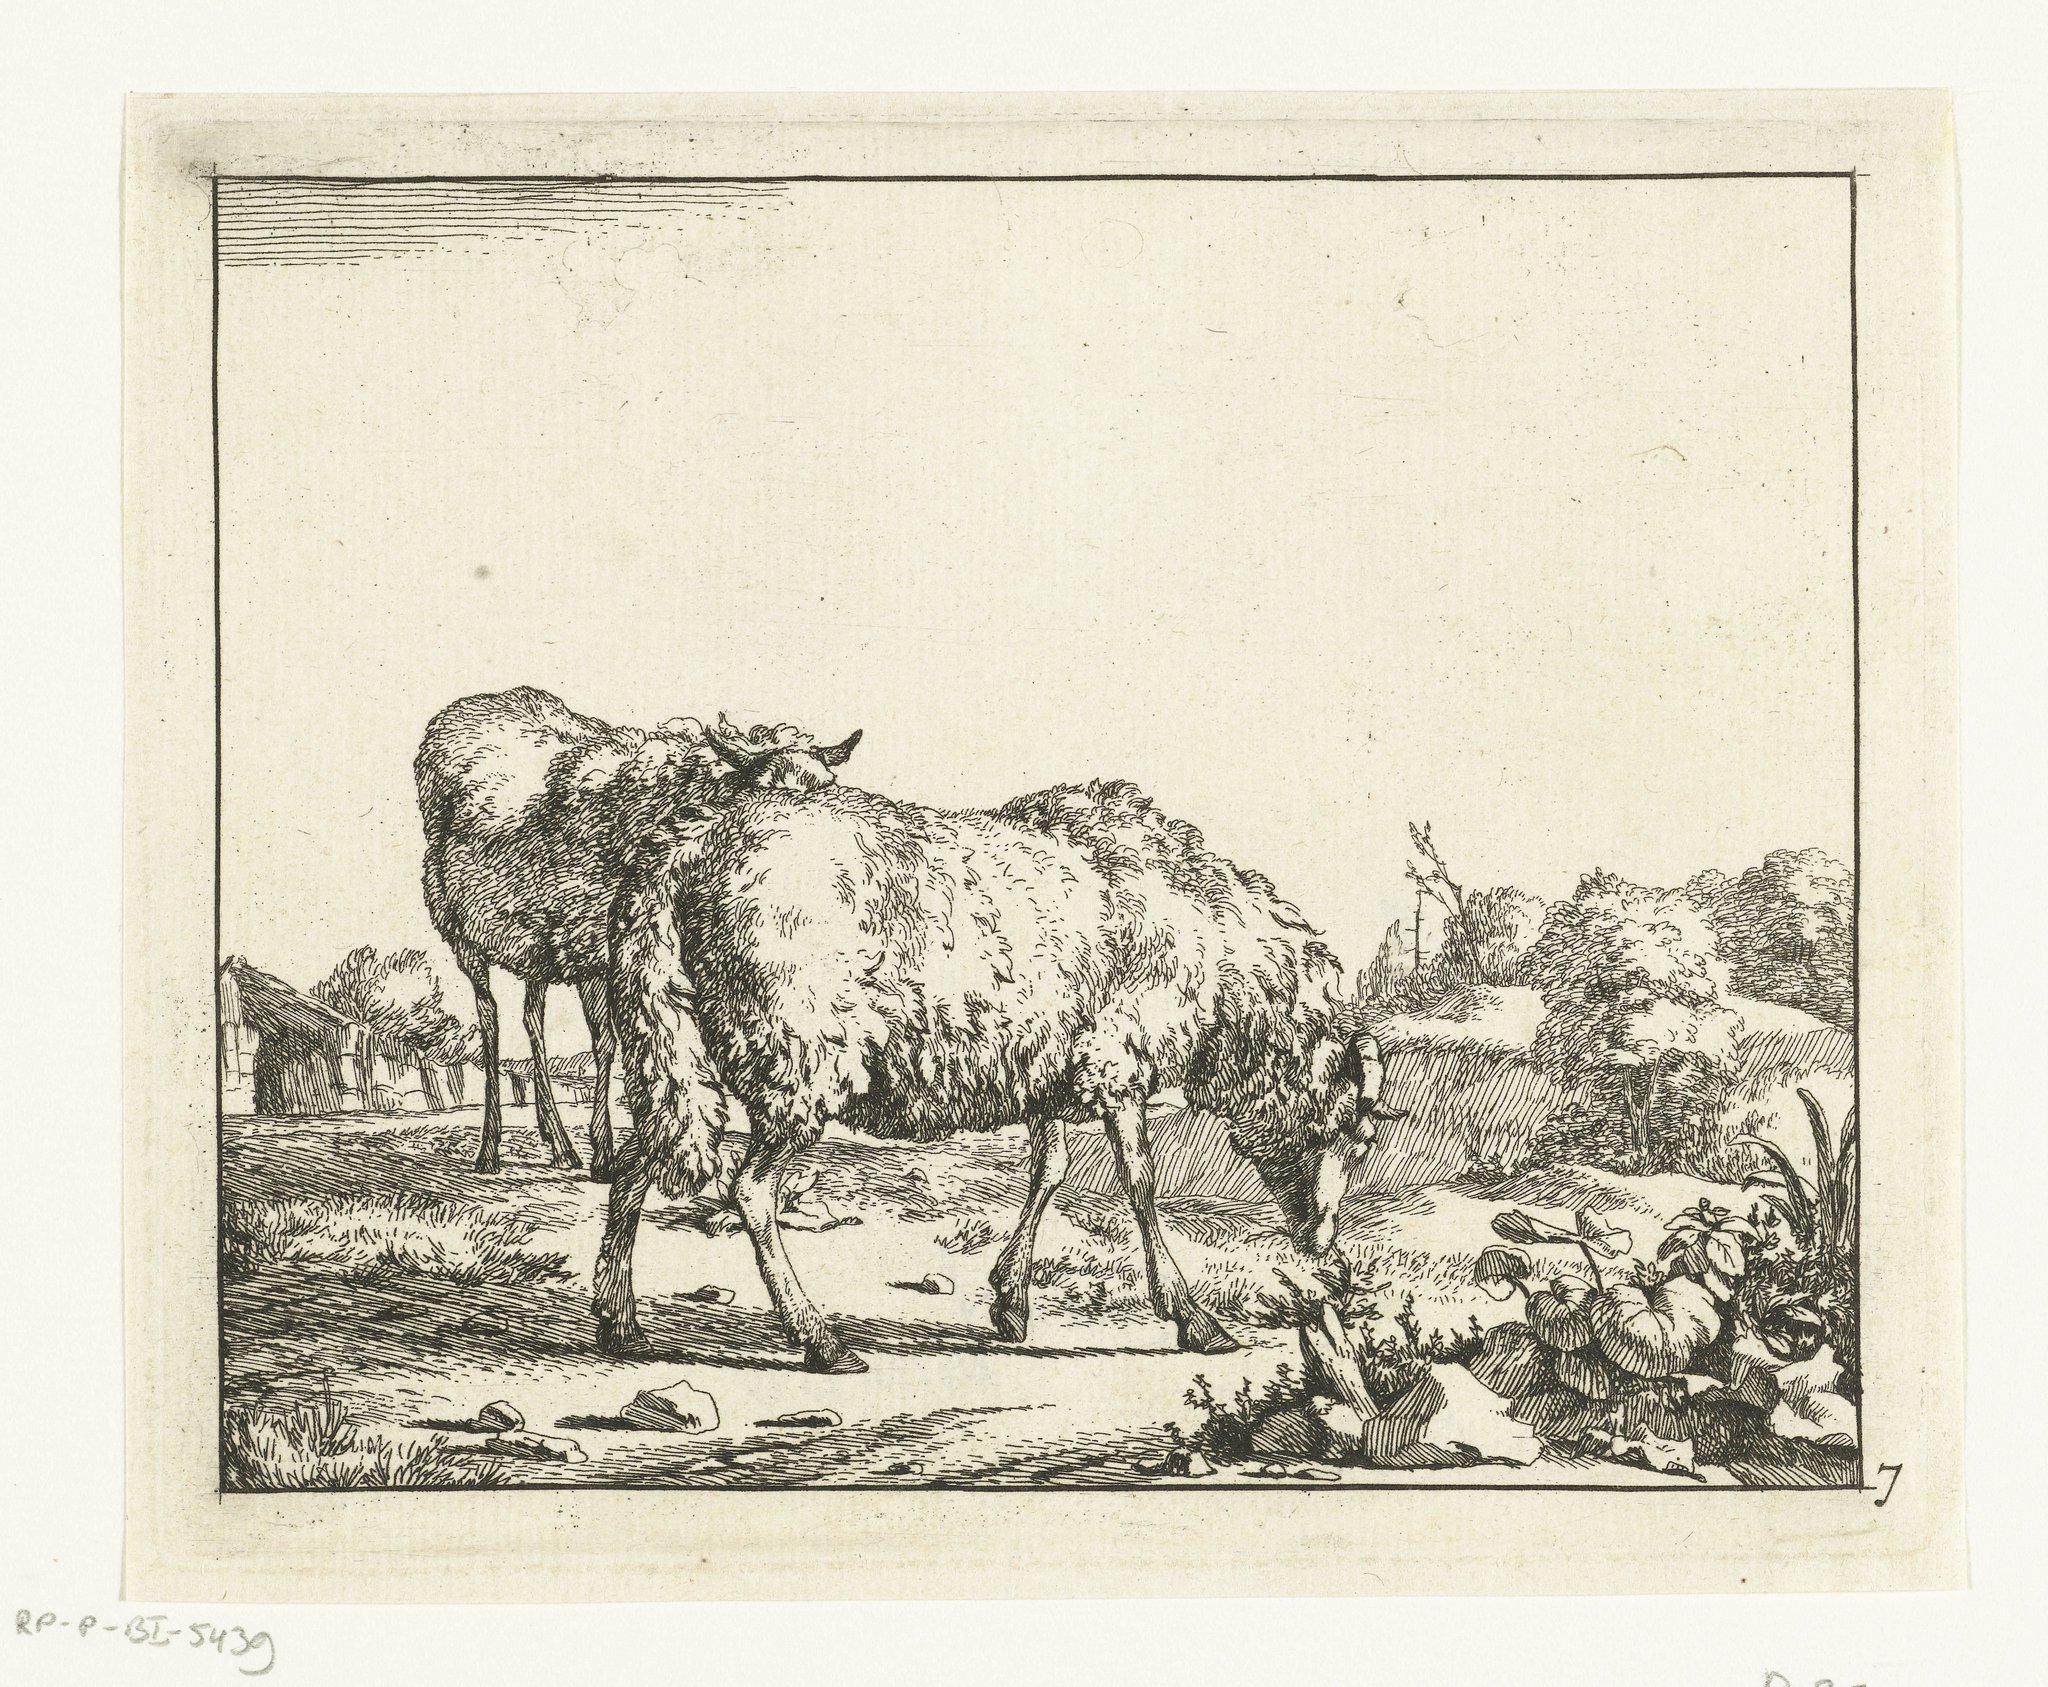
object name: print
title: Schapen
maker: marcus de bye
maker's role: print maker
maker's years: 1639-1688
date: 1664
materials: paper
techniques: etching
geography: the hague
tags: sheep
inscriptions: collector's mark: Lugt 2228